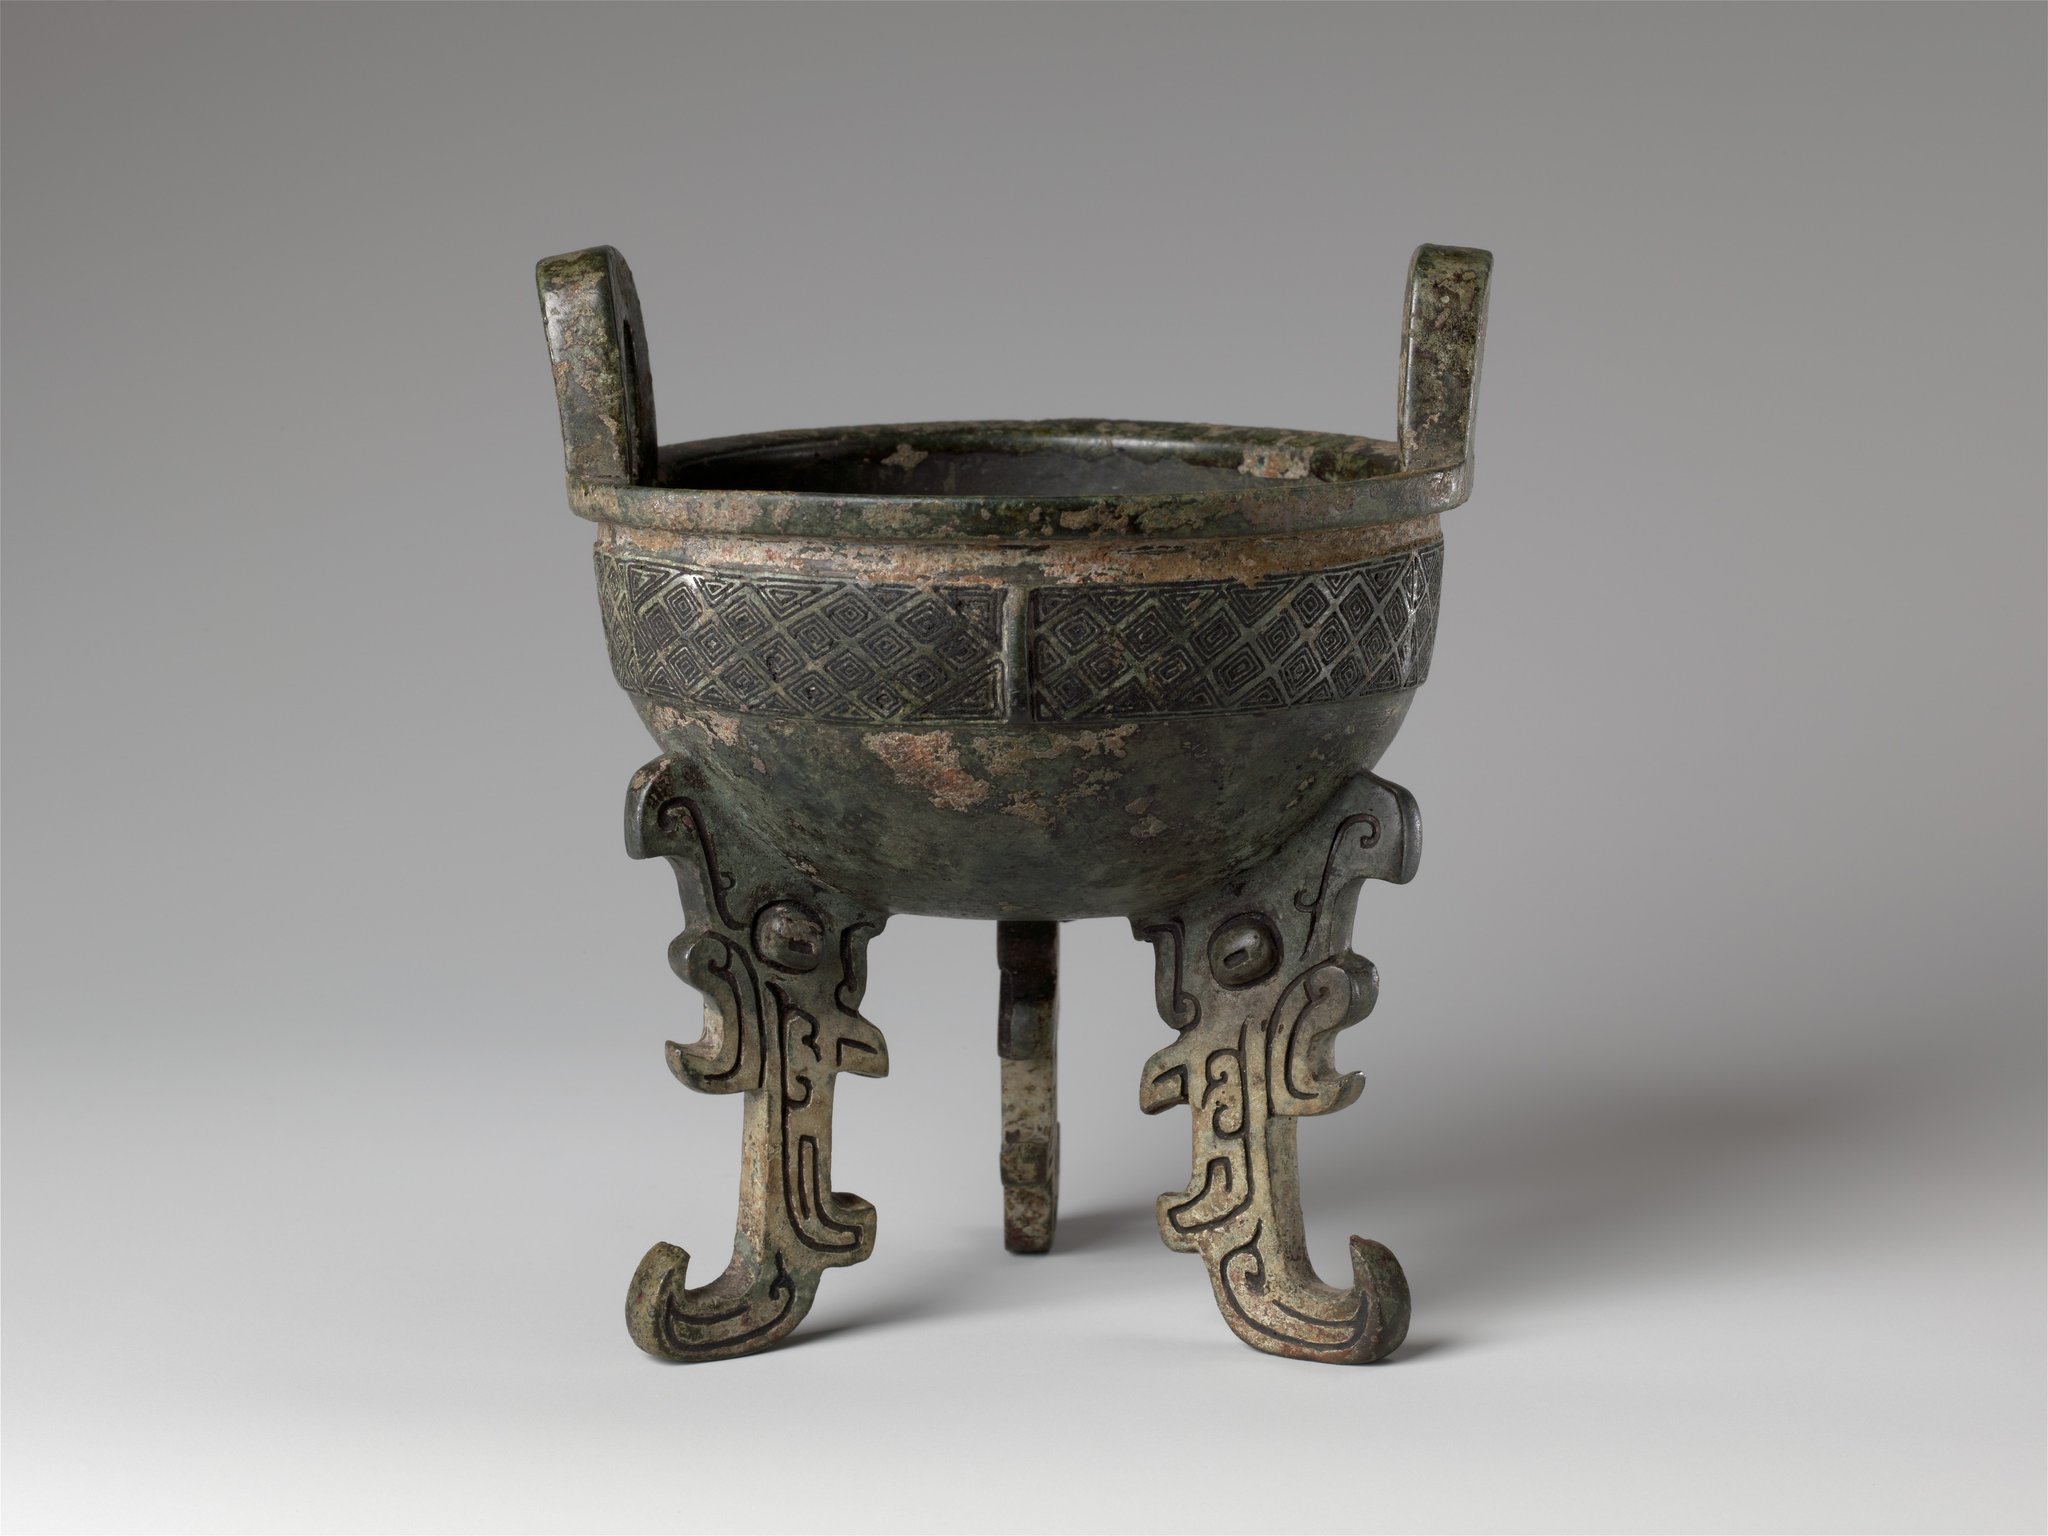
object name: cauldron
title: Tripod cauldron (ding)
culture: chinese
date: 1100-1001 BCE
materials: bronze, pigment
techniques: inlay